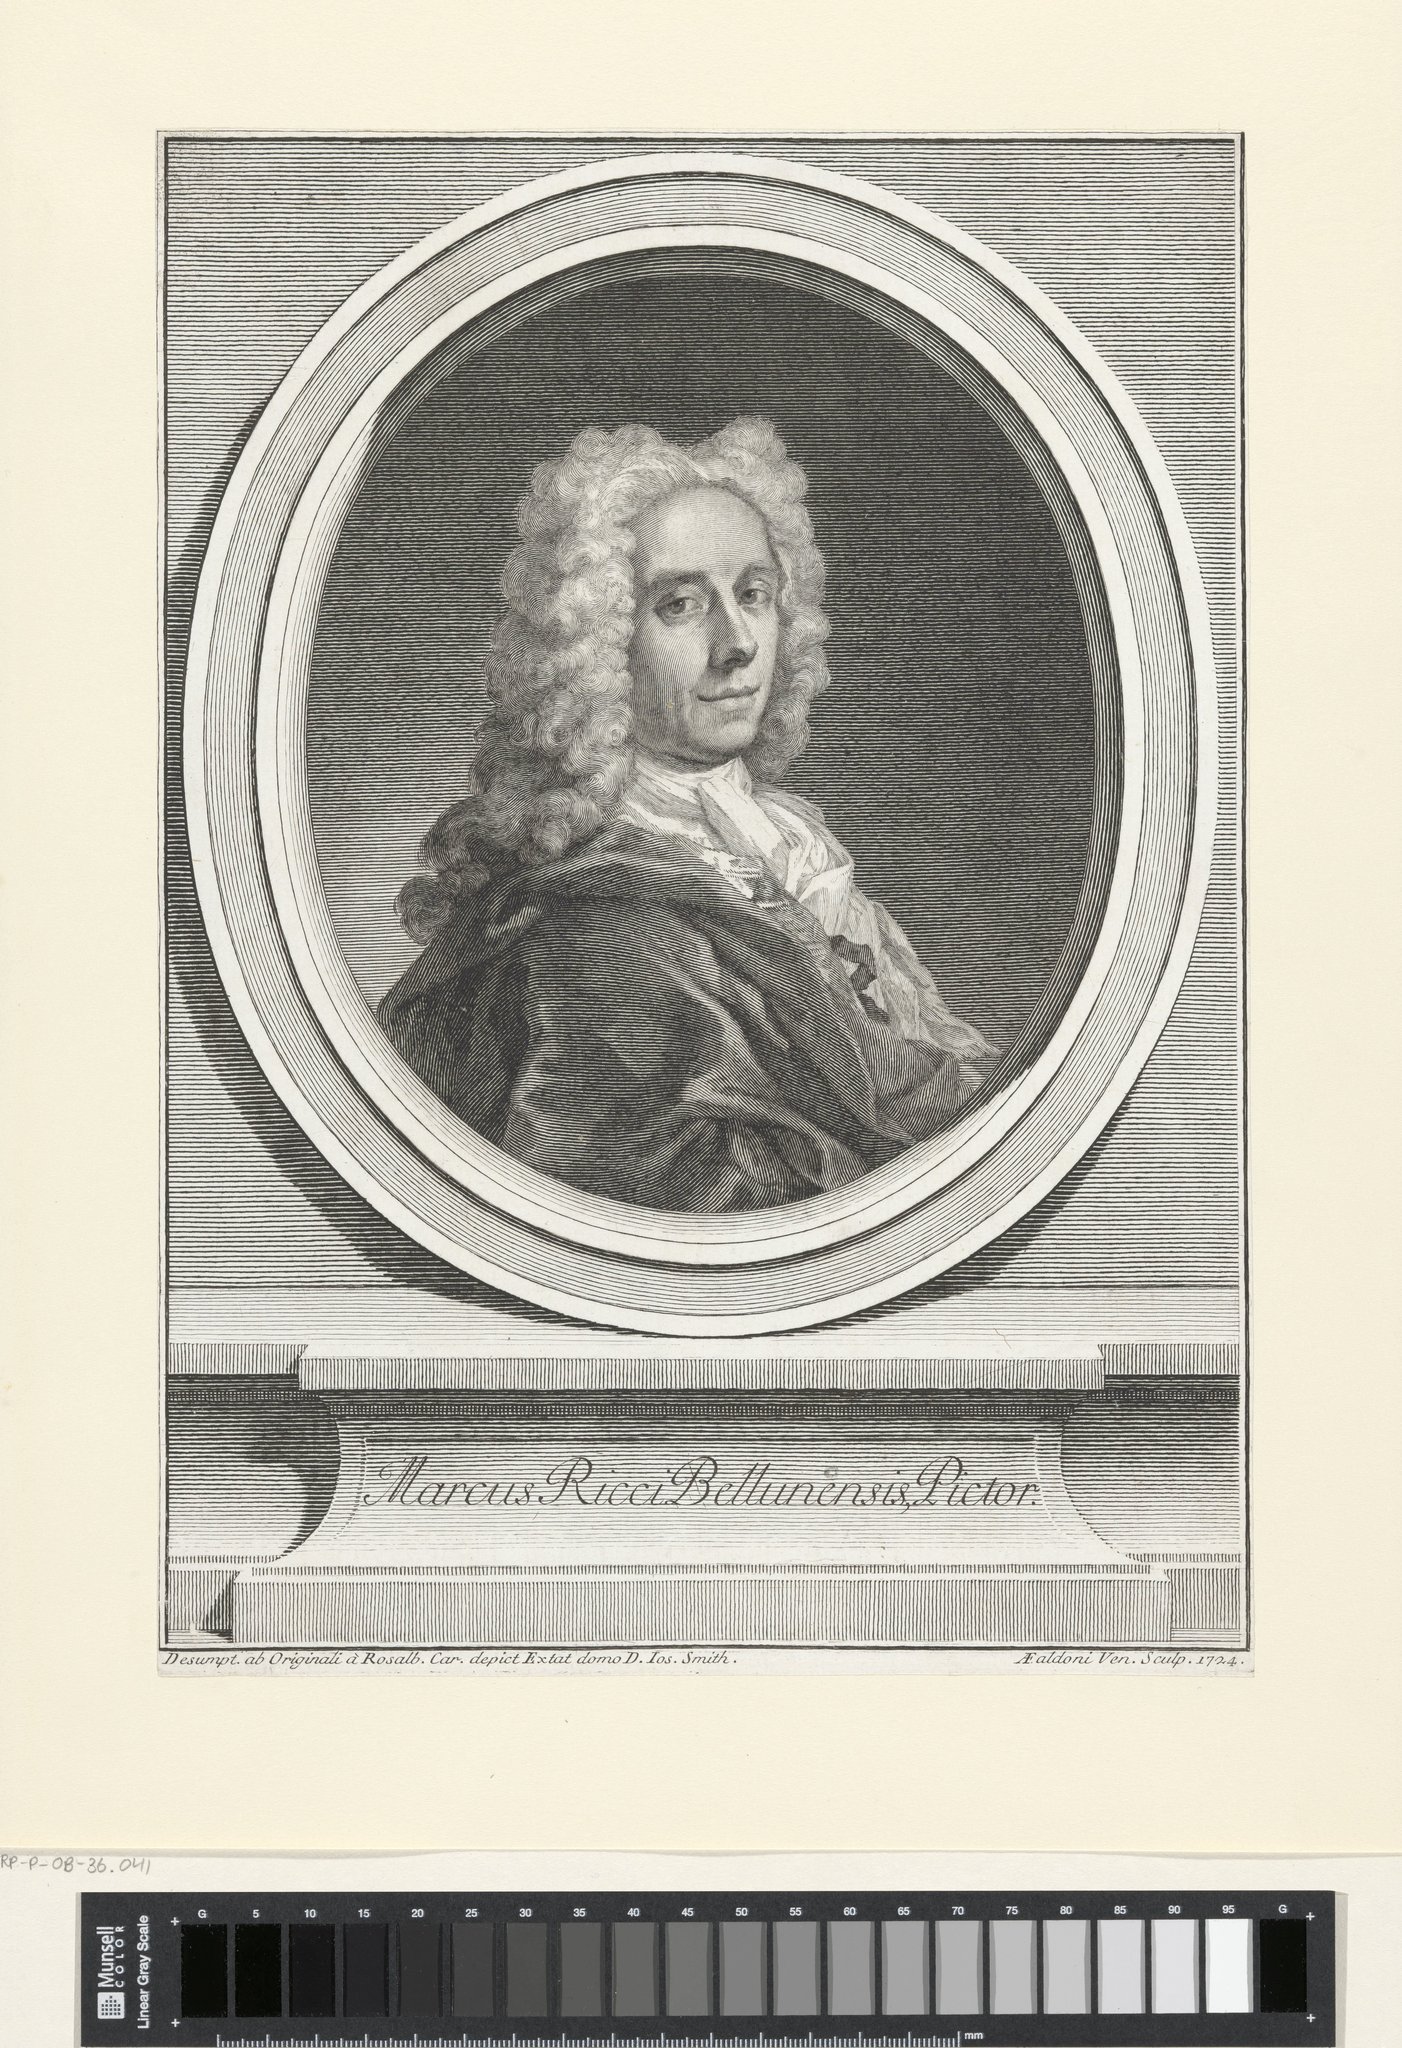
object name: print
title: Portret van schilder Marco Ricci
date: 1724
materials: paper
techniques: engraving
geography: italy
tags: venice, painter, print maker, draughtsman, marco ricci, historical persons, portrait, self-portrait of artist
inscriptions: collector's mark: Lugt 2228